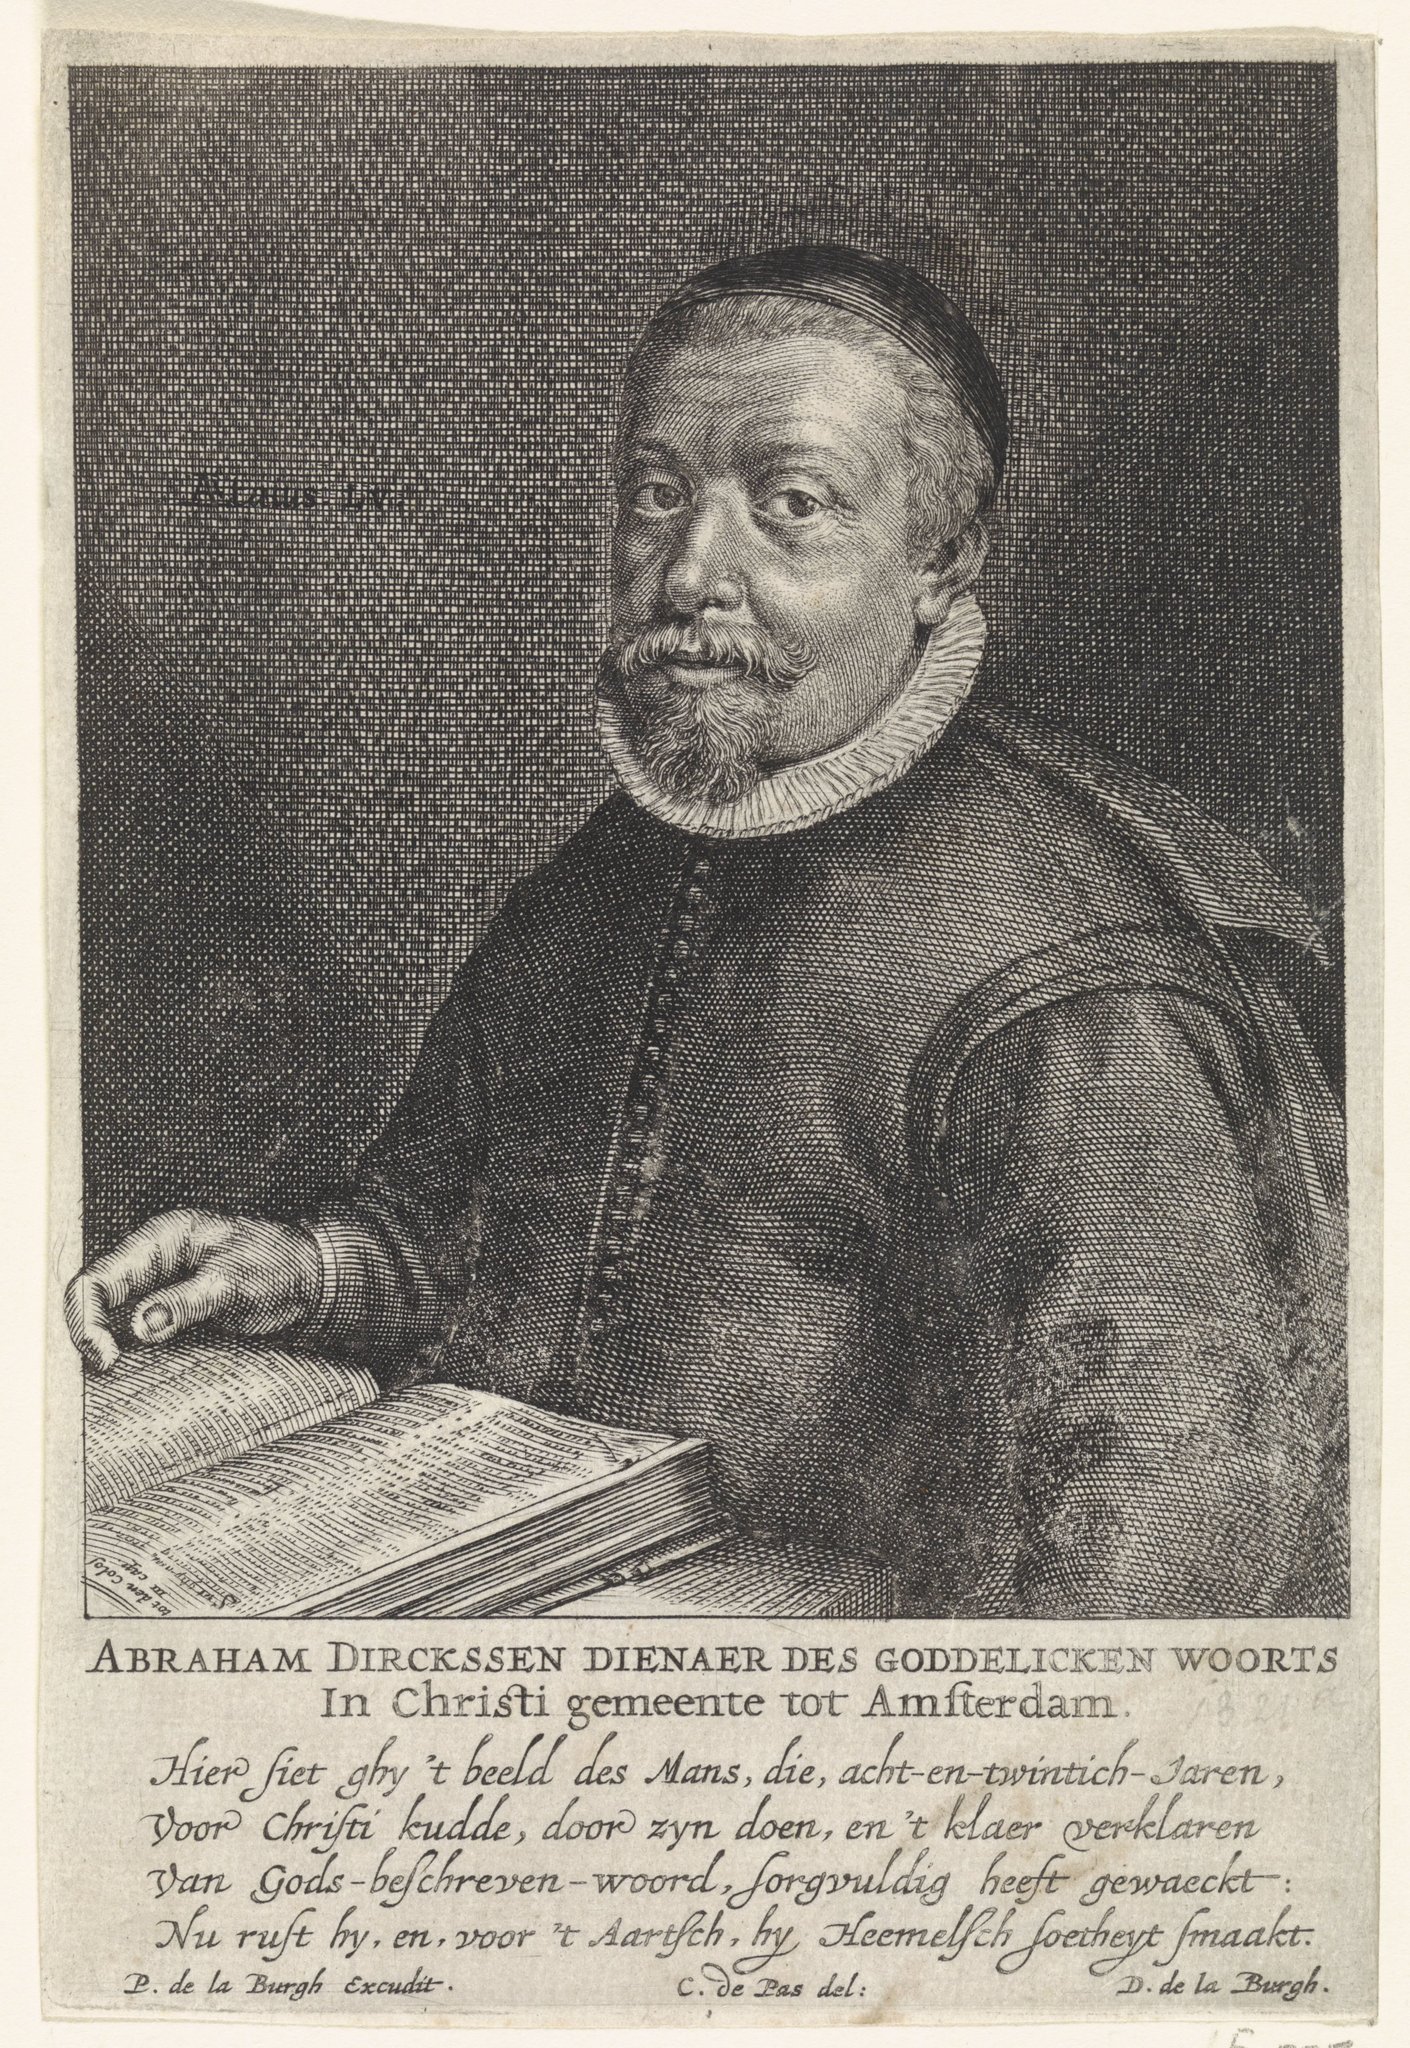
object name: print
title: Portret van Abraham Dirksz. Bierens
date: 1604-1670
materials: paper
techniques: engraving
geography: amsterdam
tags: dordrecht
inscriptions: collector's mark: Lugt 2228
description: Portret van de predikant Abraham Dirksz. Bierens, op 55-jarige leeftijd. In de marge de naam en functie van de geportretteerde in het Nederlands en een vierregelig lofdicht in het Nederlands.